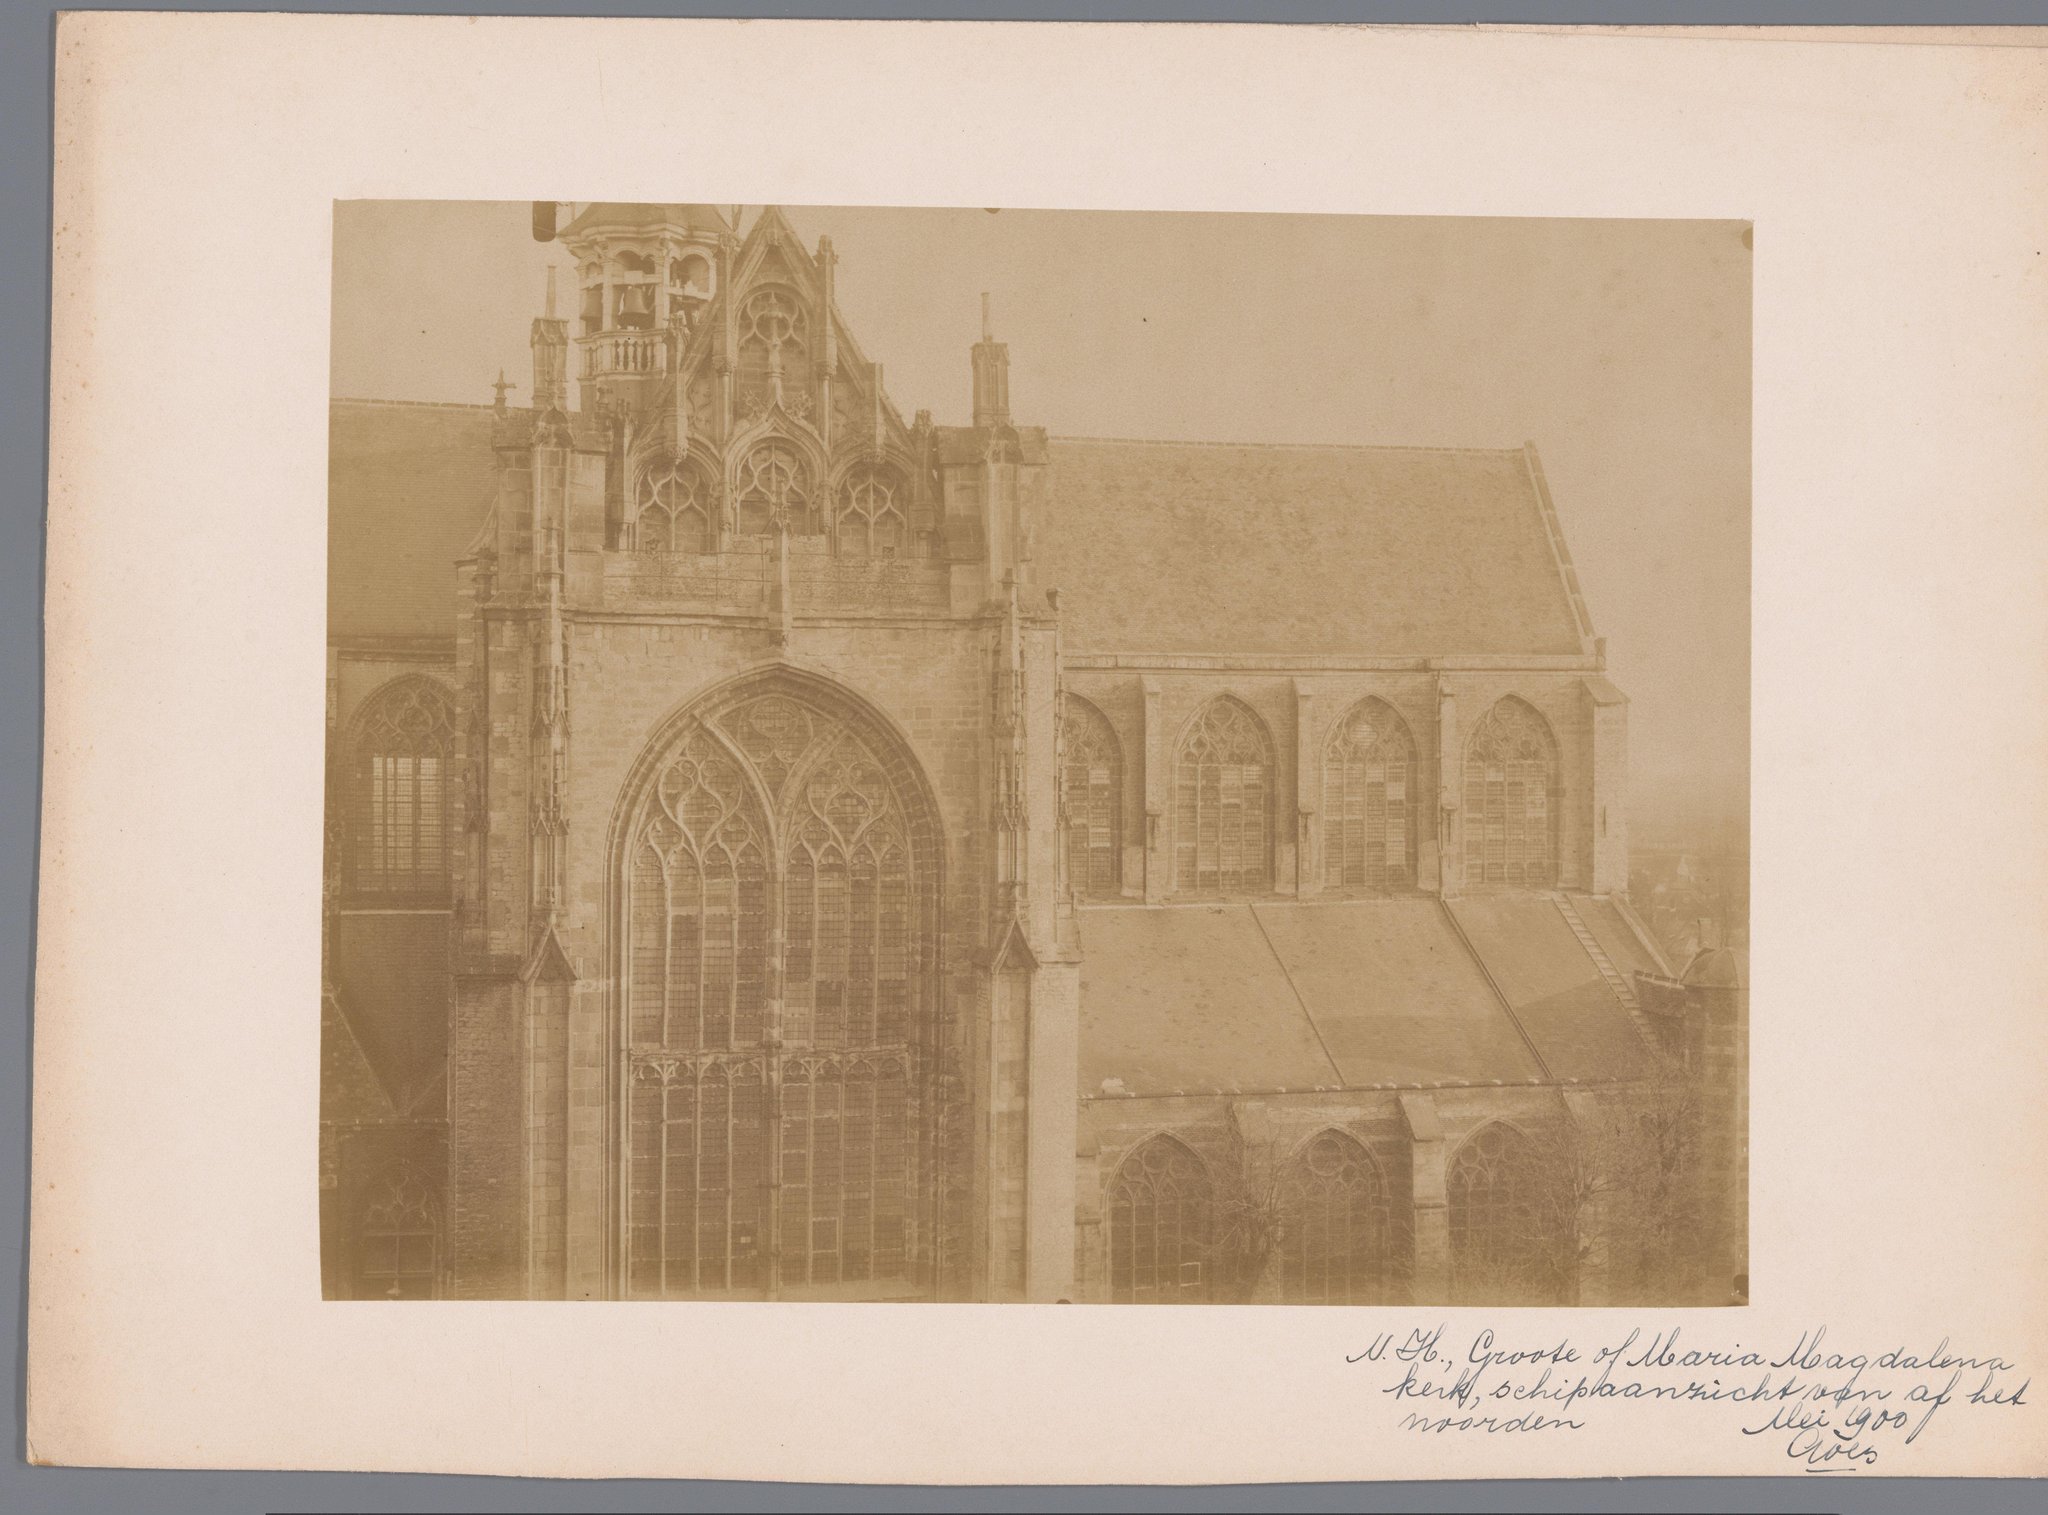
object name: photograph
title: Noordzijde van de Grote of Maria Magdalenakerk te Goes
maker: anoniem (monumentenzorg)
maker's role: fotograaf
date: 1900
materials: cardboard, photographic support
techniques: albumen print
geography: goes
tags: church (exterior)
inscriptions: annotation: ‘N.H., Groote of Maria Magdalenakerk, schip aanzicht van af het noorden/ Goes’, annotation: ‘Groote of St. Magdalenakerk te Goes (Z.)/ Schip aangezicht van af het noorden/ Mei 1900’